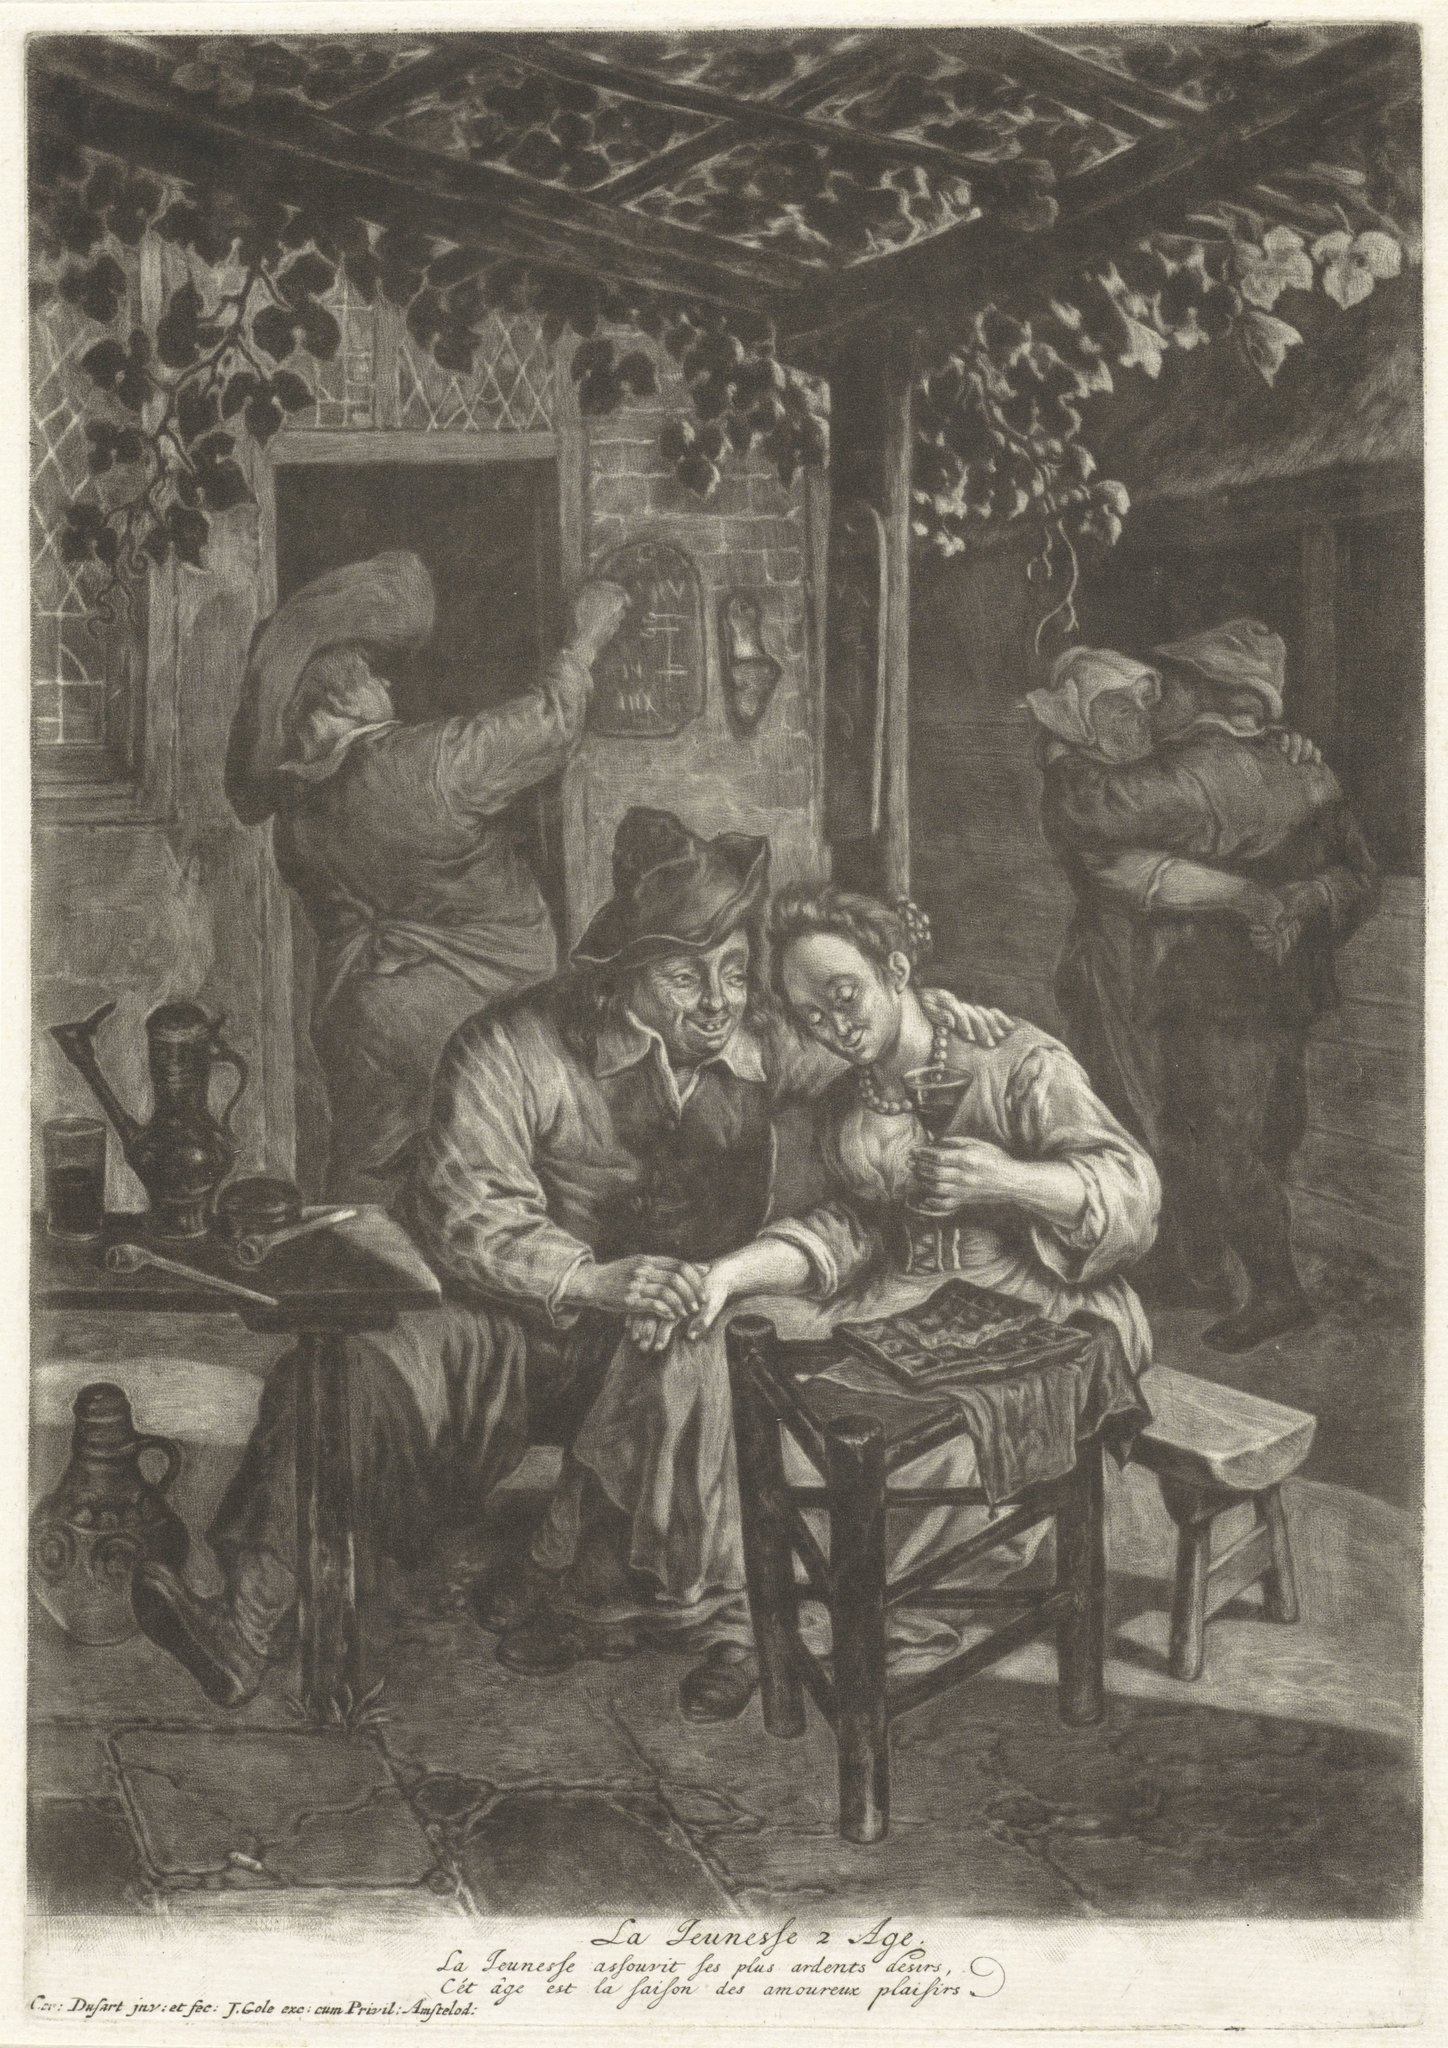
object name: print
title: De jeugd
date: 1680-1704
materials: paper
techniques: engraving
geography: amsterdam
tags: youth, adolescent, human life divided into stages, e.g. three, four, seven, twelve stages (with number), terrace, couple of lovers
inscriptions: collector's mark: Lugt 2909a, collector's mark: Lugt 2228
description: Op een terras voor een herberg onder een pergola zit een jong liefdespaar in een intieme houding bij een tafel. Ze eten wafels en drinken wijn en bier. Op de achtergrond een tweede liefdespaar in een omhelzing. De prent is onderdeel van een reeks van vier prenten over de leeftijden van de mens.